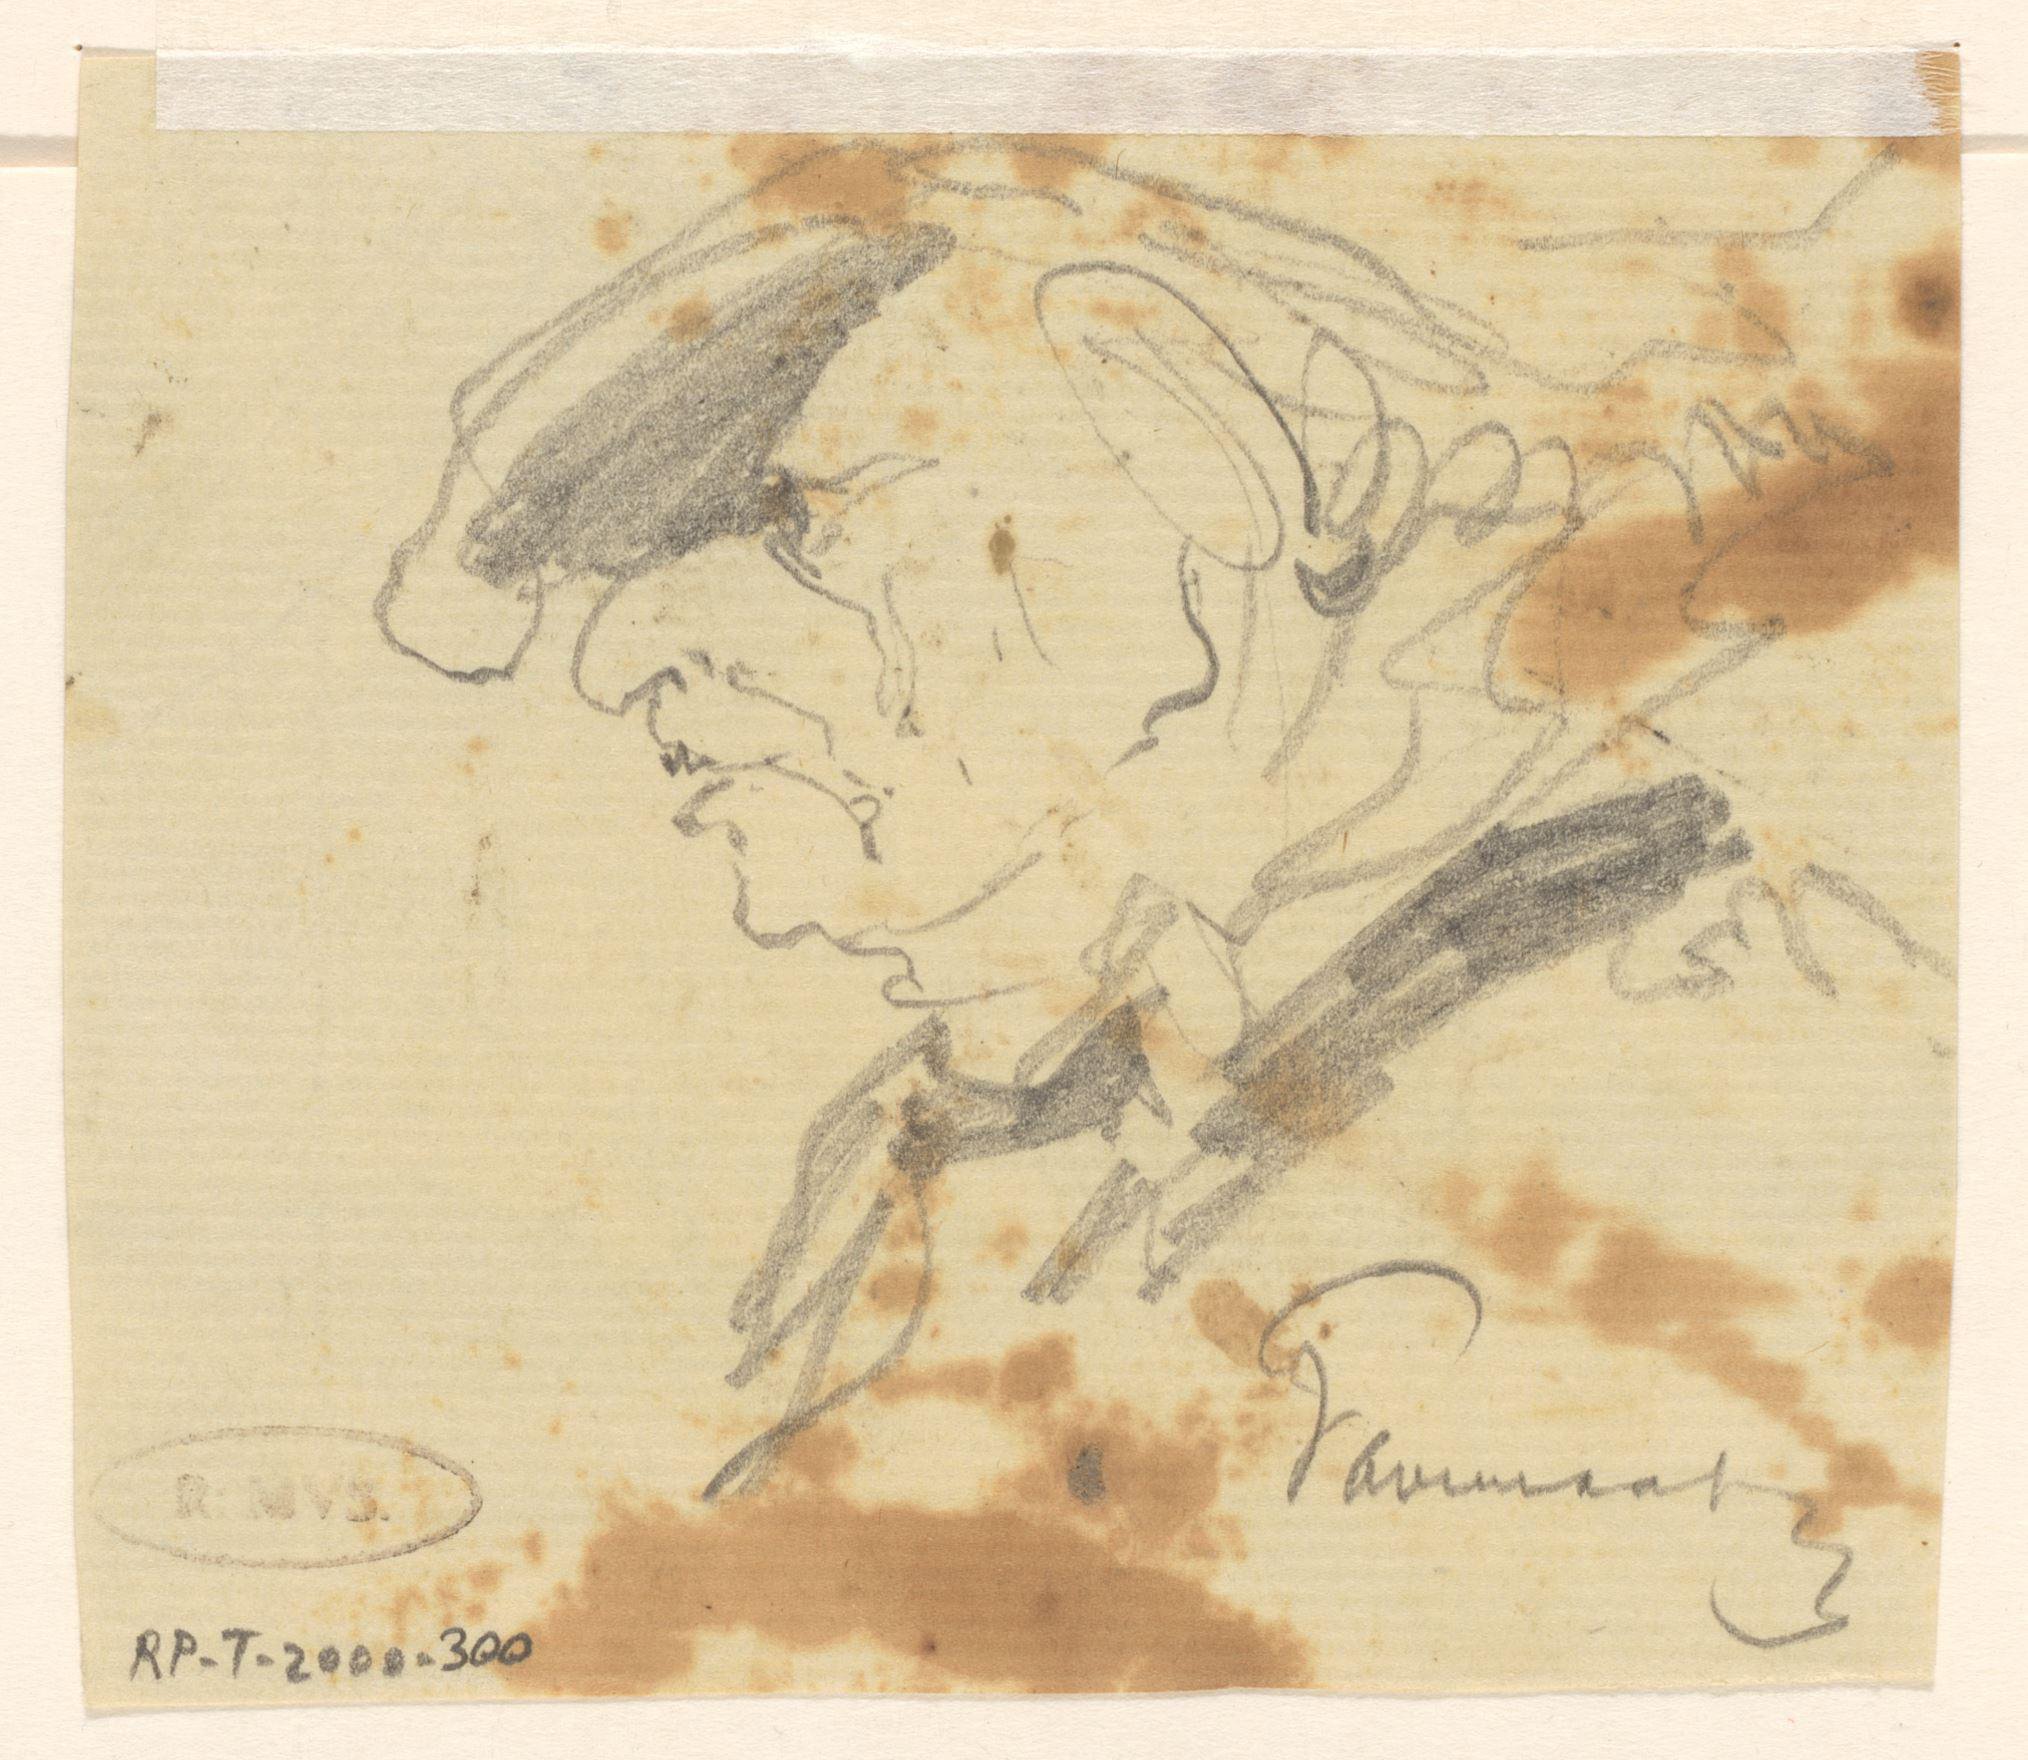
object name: drawing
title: Kop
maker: johannes tavenraat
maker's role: draughtsman, painter, print maker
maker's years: 1809-1881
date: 1840-1880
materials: paper, pencil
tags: caricatures (human types)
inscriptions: collector's mark: Lugt 2228, signature: ‘Tavenraat’